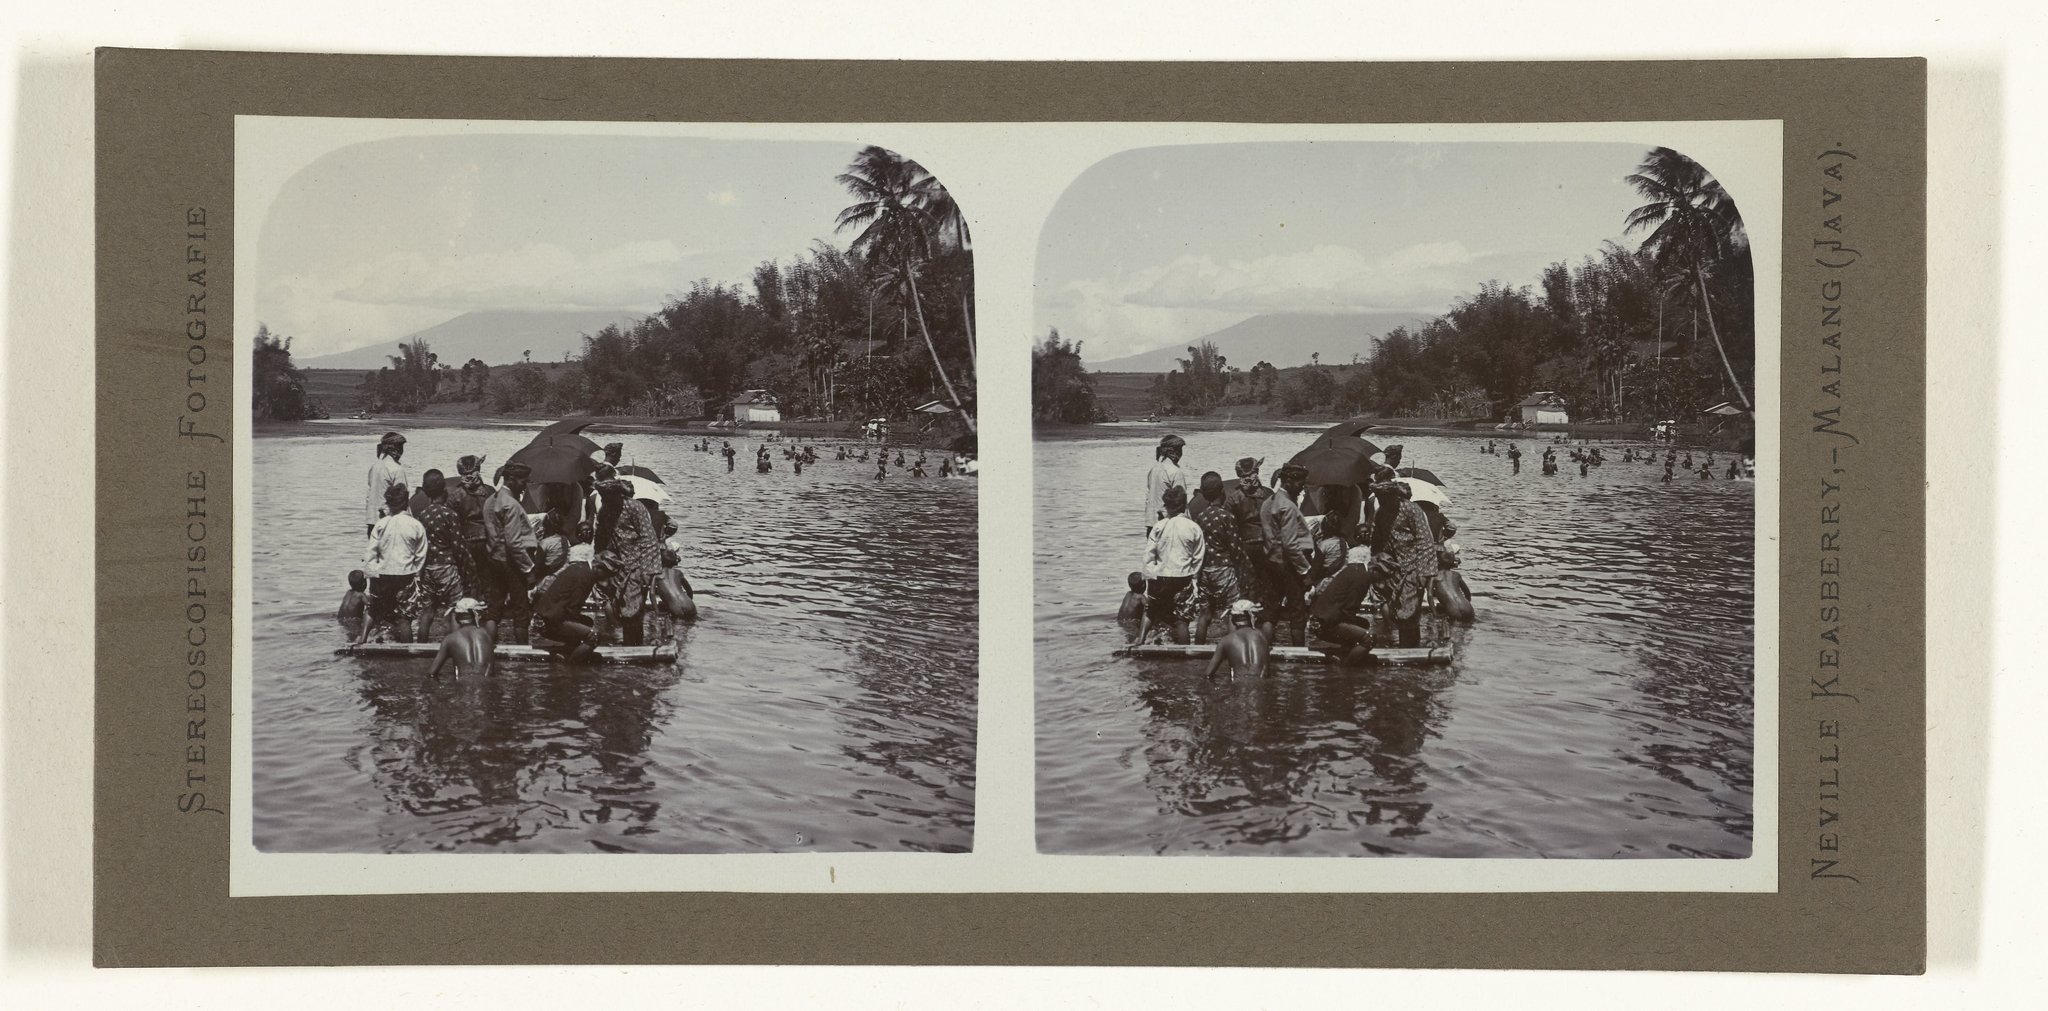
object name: stereograph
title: S 2 No 16. Volksvermaak op 't Meer van Wendit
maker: neville keasberry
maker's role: fotograaf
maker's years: 1866-1944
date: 1900-1935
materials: cardboard, paper, photographic support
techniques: albumen print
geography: malang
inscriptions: signature: ‘Neville Keasberry, Malang (Java)’, inscription: ‘Stereoscopische Fotografie’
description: Javaanse eettentjes in de buitenlucht op een druk bezocht terrein.